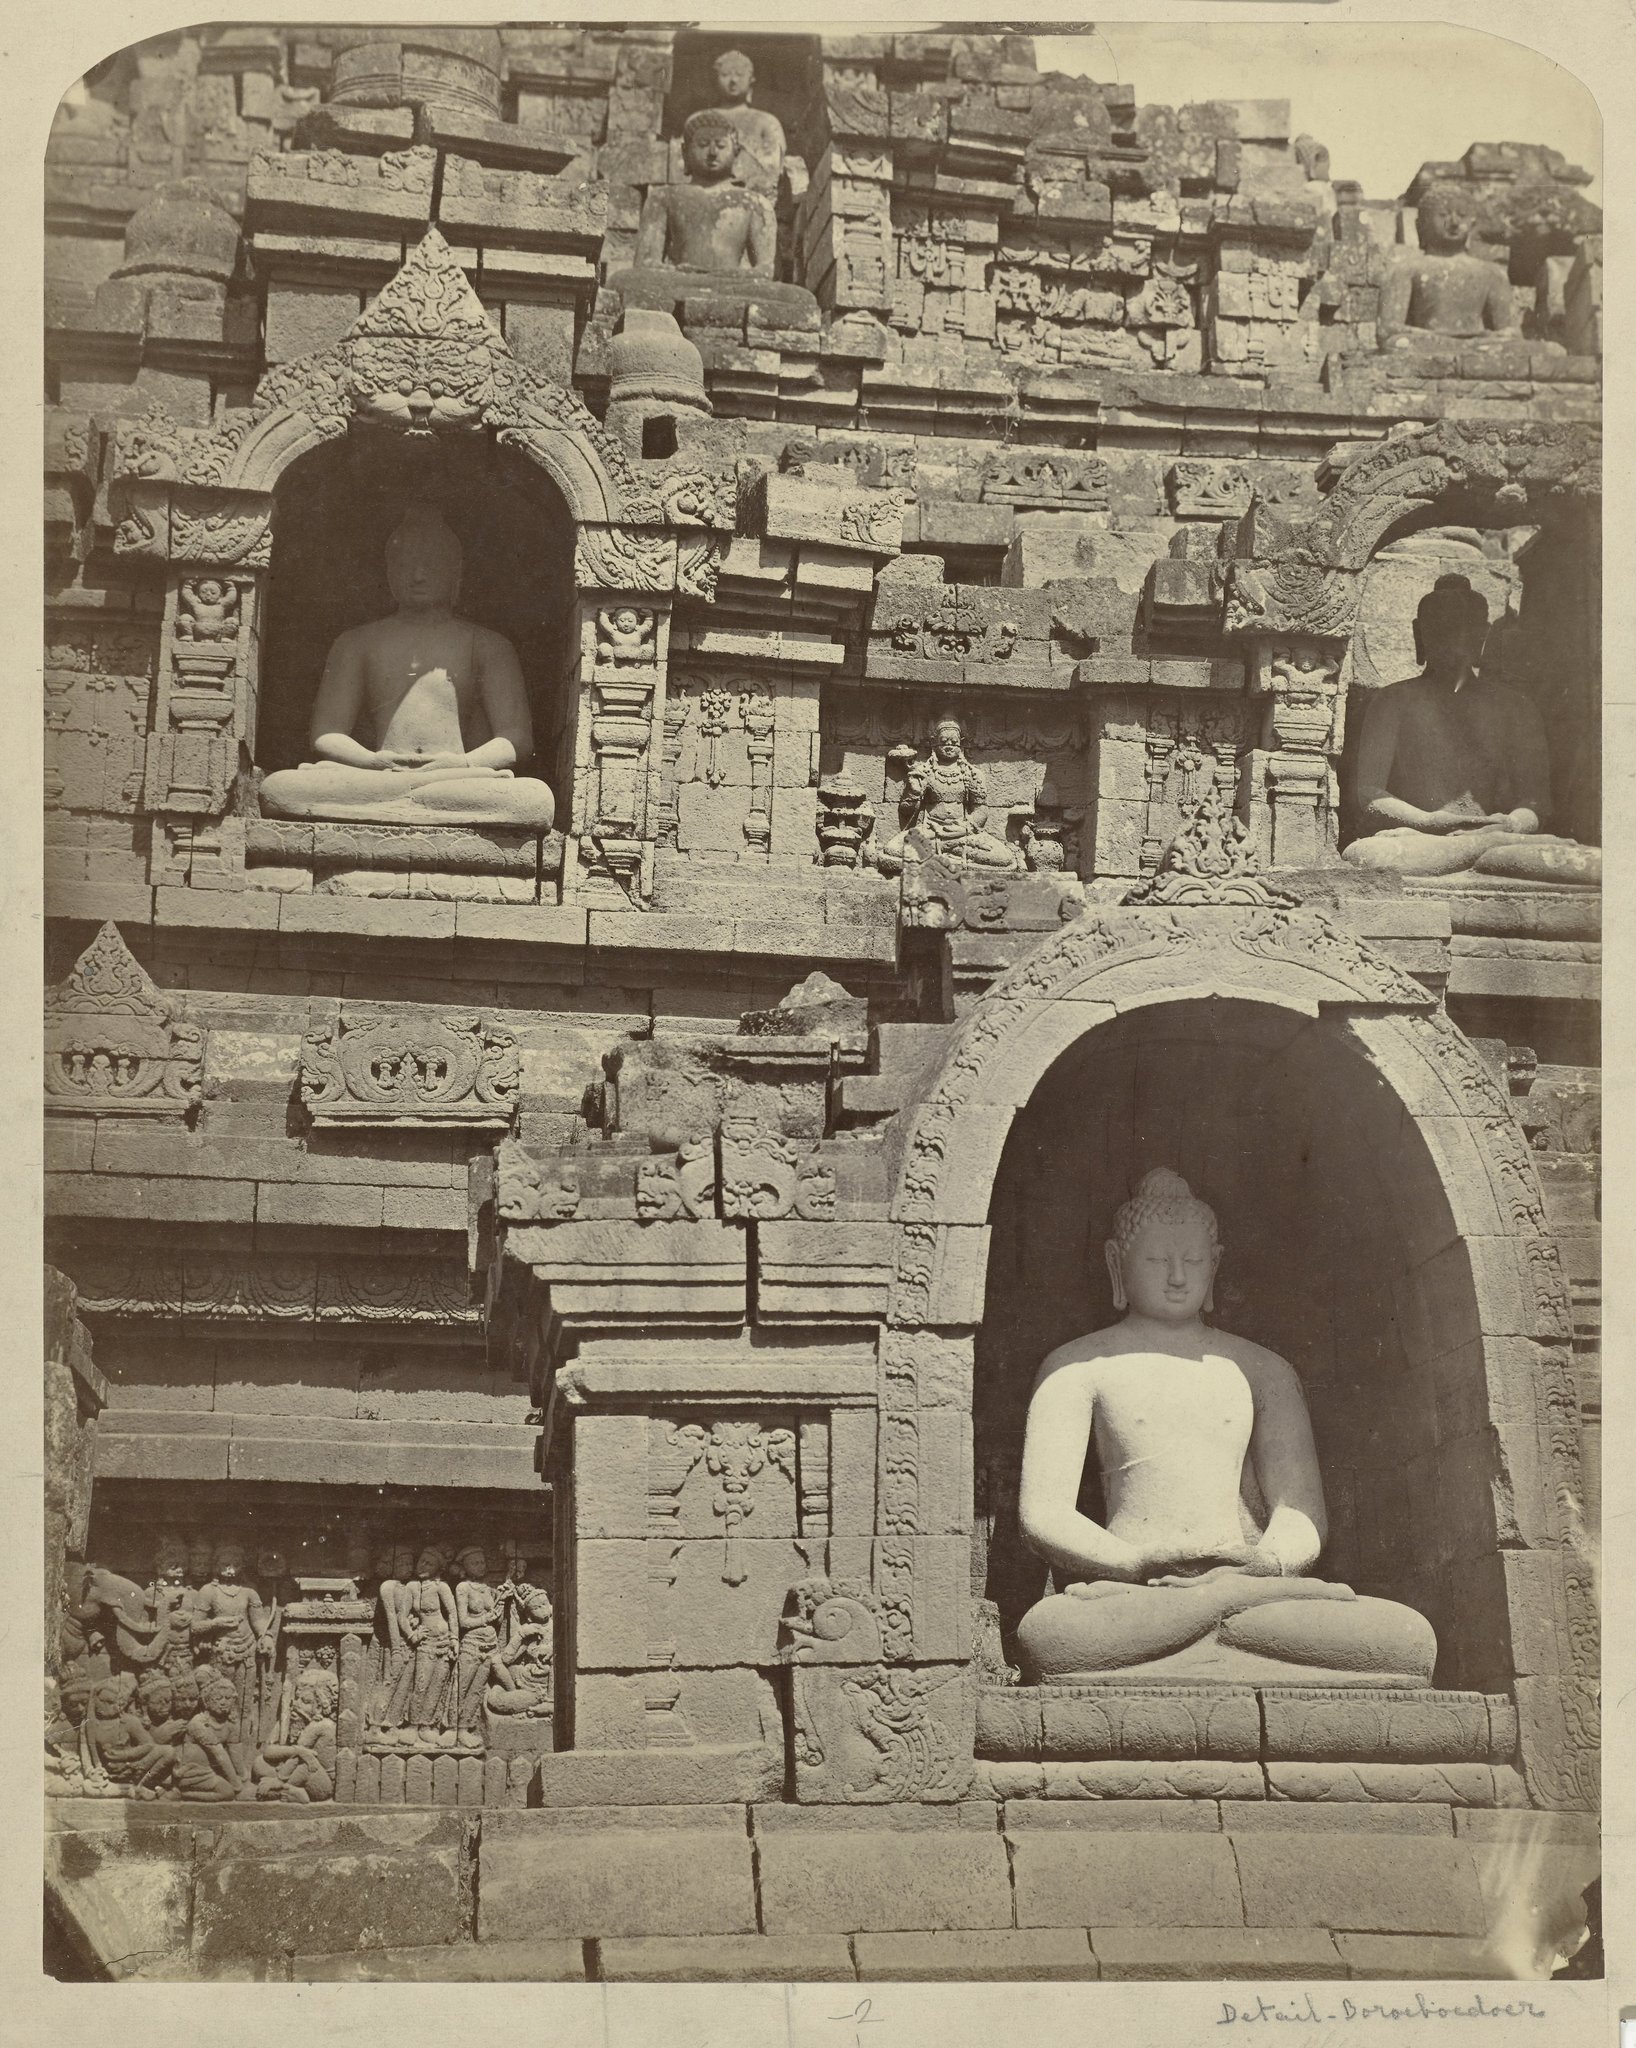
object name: photograph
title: Vier nissen in de Borobudur met daarin Boeddha figuren in dhyanamudra.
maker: isidore kinsbergen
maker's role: fotograaf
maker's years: 1821-1905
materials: cardboard, paper, photographic support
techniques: albumen print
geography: java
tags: borobudur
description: Some of the 92 westerly niches with Buddha figures displaying the dhyanamudra Borobudur village, Magelang district, Central Java province, 778-824 AD.